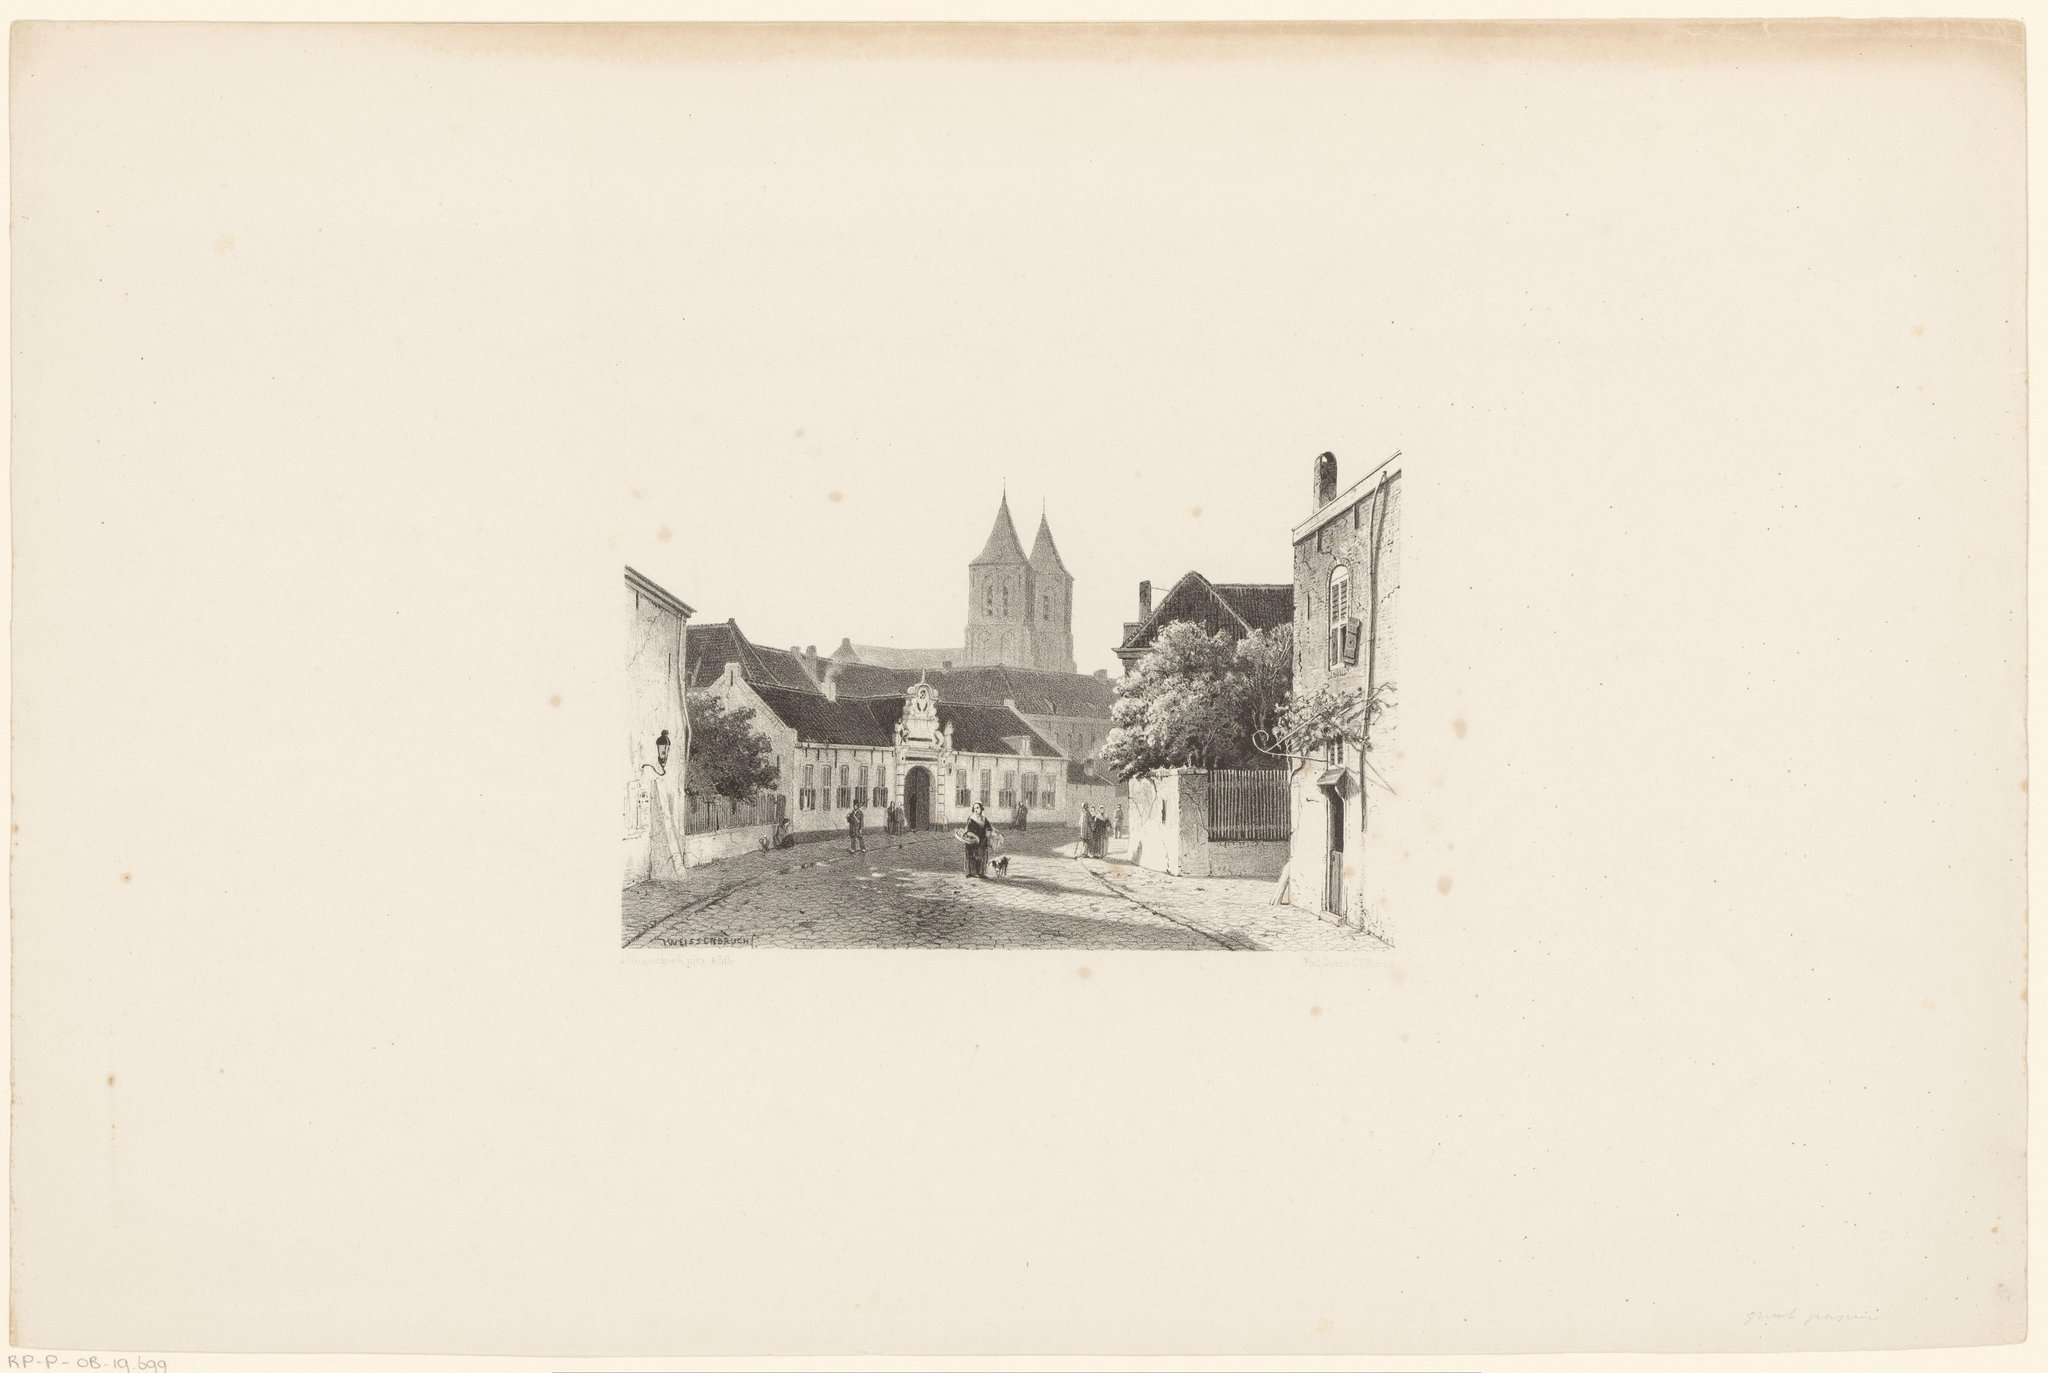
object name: print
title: Gezicht op de Beekstraat te Arnhem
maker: jan weissenbruch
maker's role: painter, print maker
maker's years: 1822-1880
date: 1847-1865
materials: paper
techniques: lithograph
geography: the hague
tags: street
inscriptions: collector's mark: Lugt 2228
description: De Beekstraat met het Sint-Catharina Gasthuis en de Sint-Walburgiskerk.